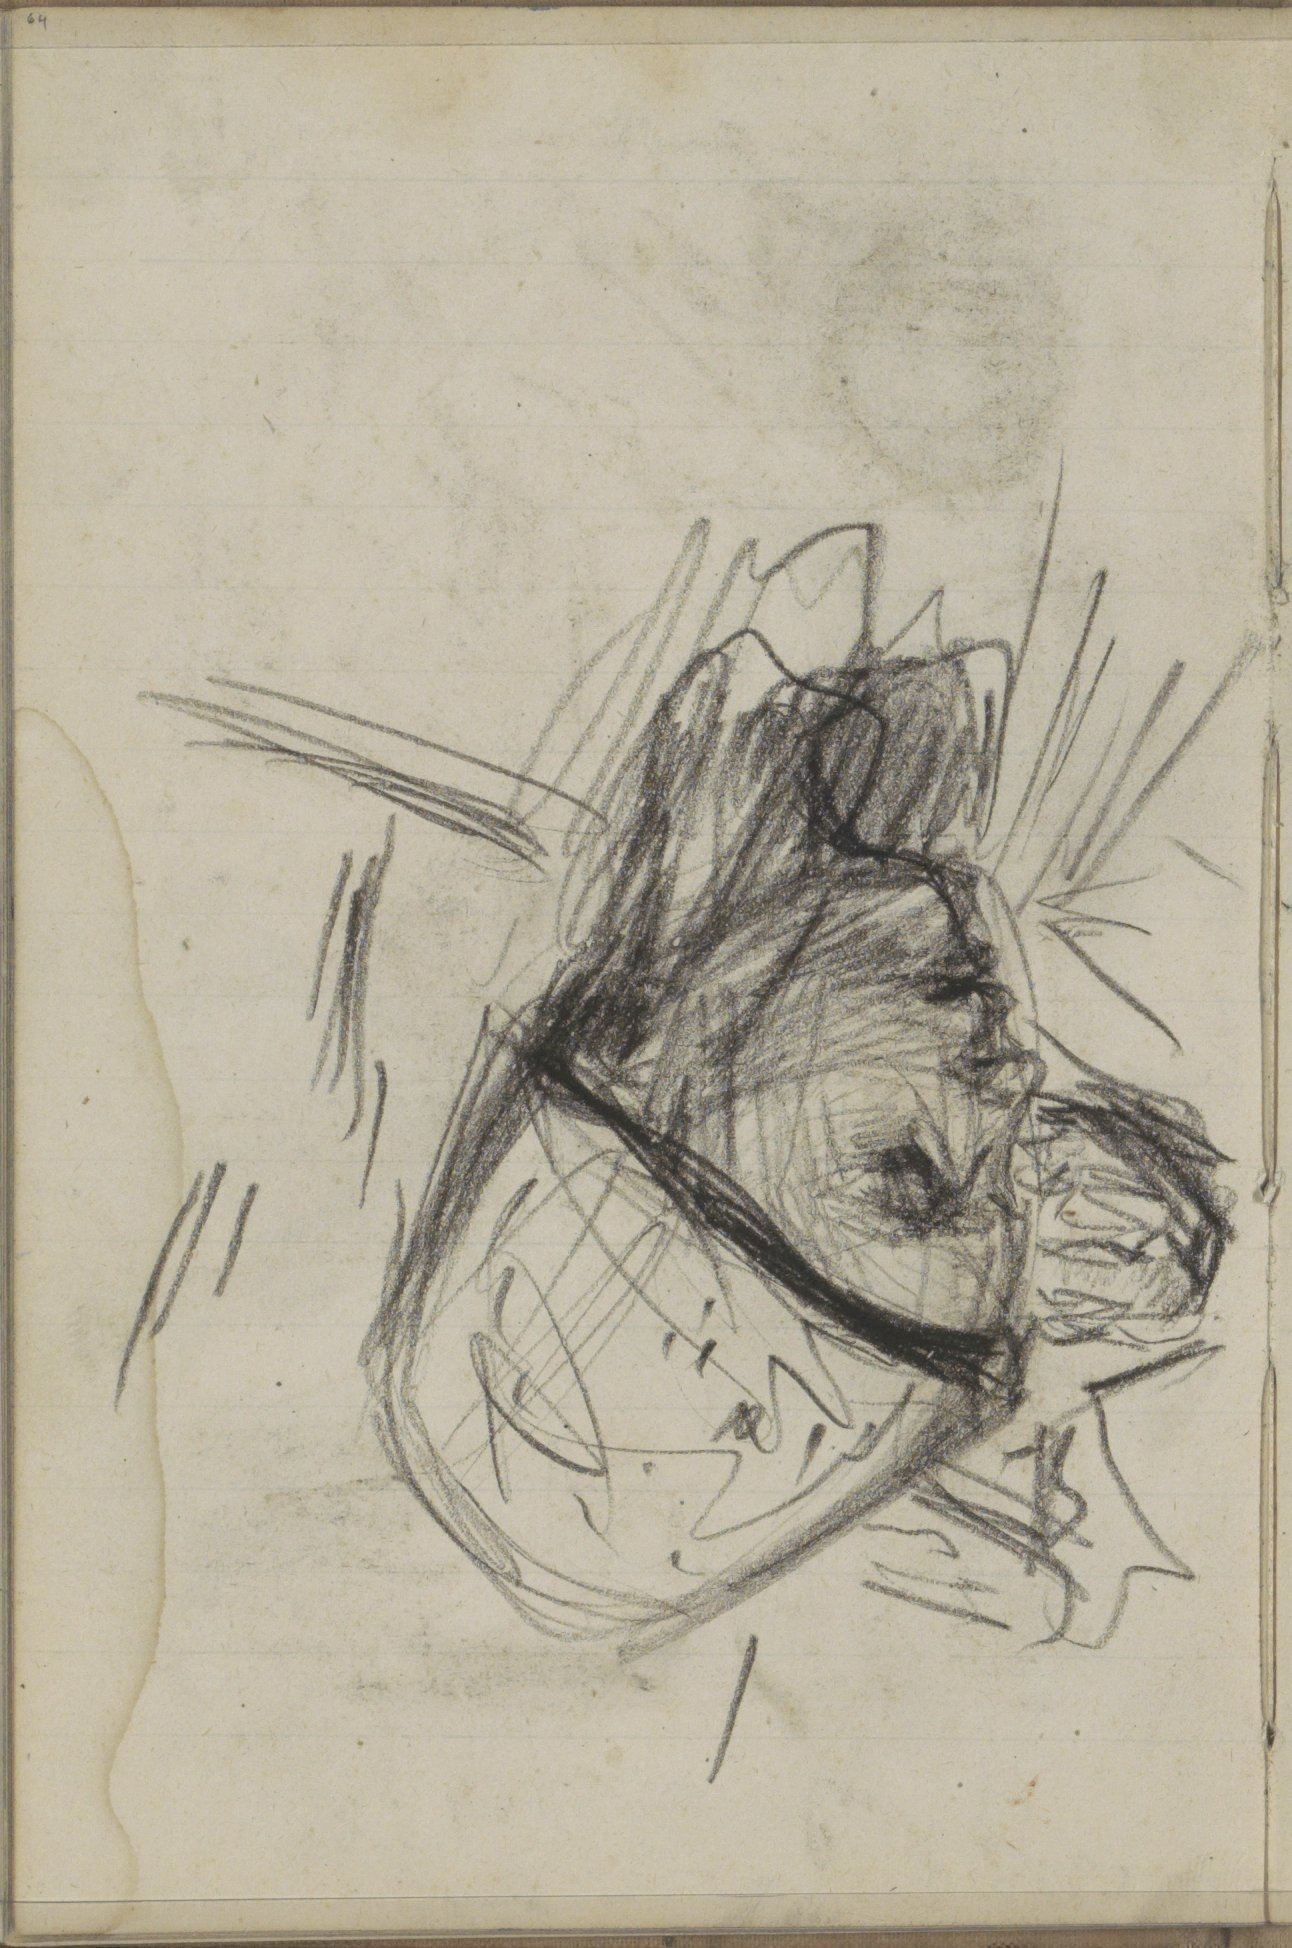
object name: sketchbook leaf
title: Kop van een jongen met een oosters hoofddeksel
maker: marius bauer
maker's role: draughtsman, print maker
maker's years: 1867-1932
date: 1888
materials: chalk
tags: head (human), head-gear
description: Pagina 64 uit een schetsboek met 49 bladen.